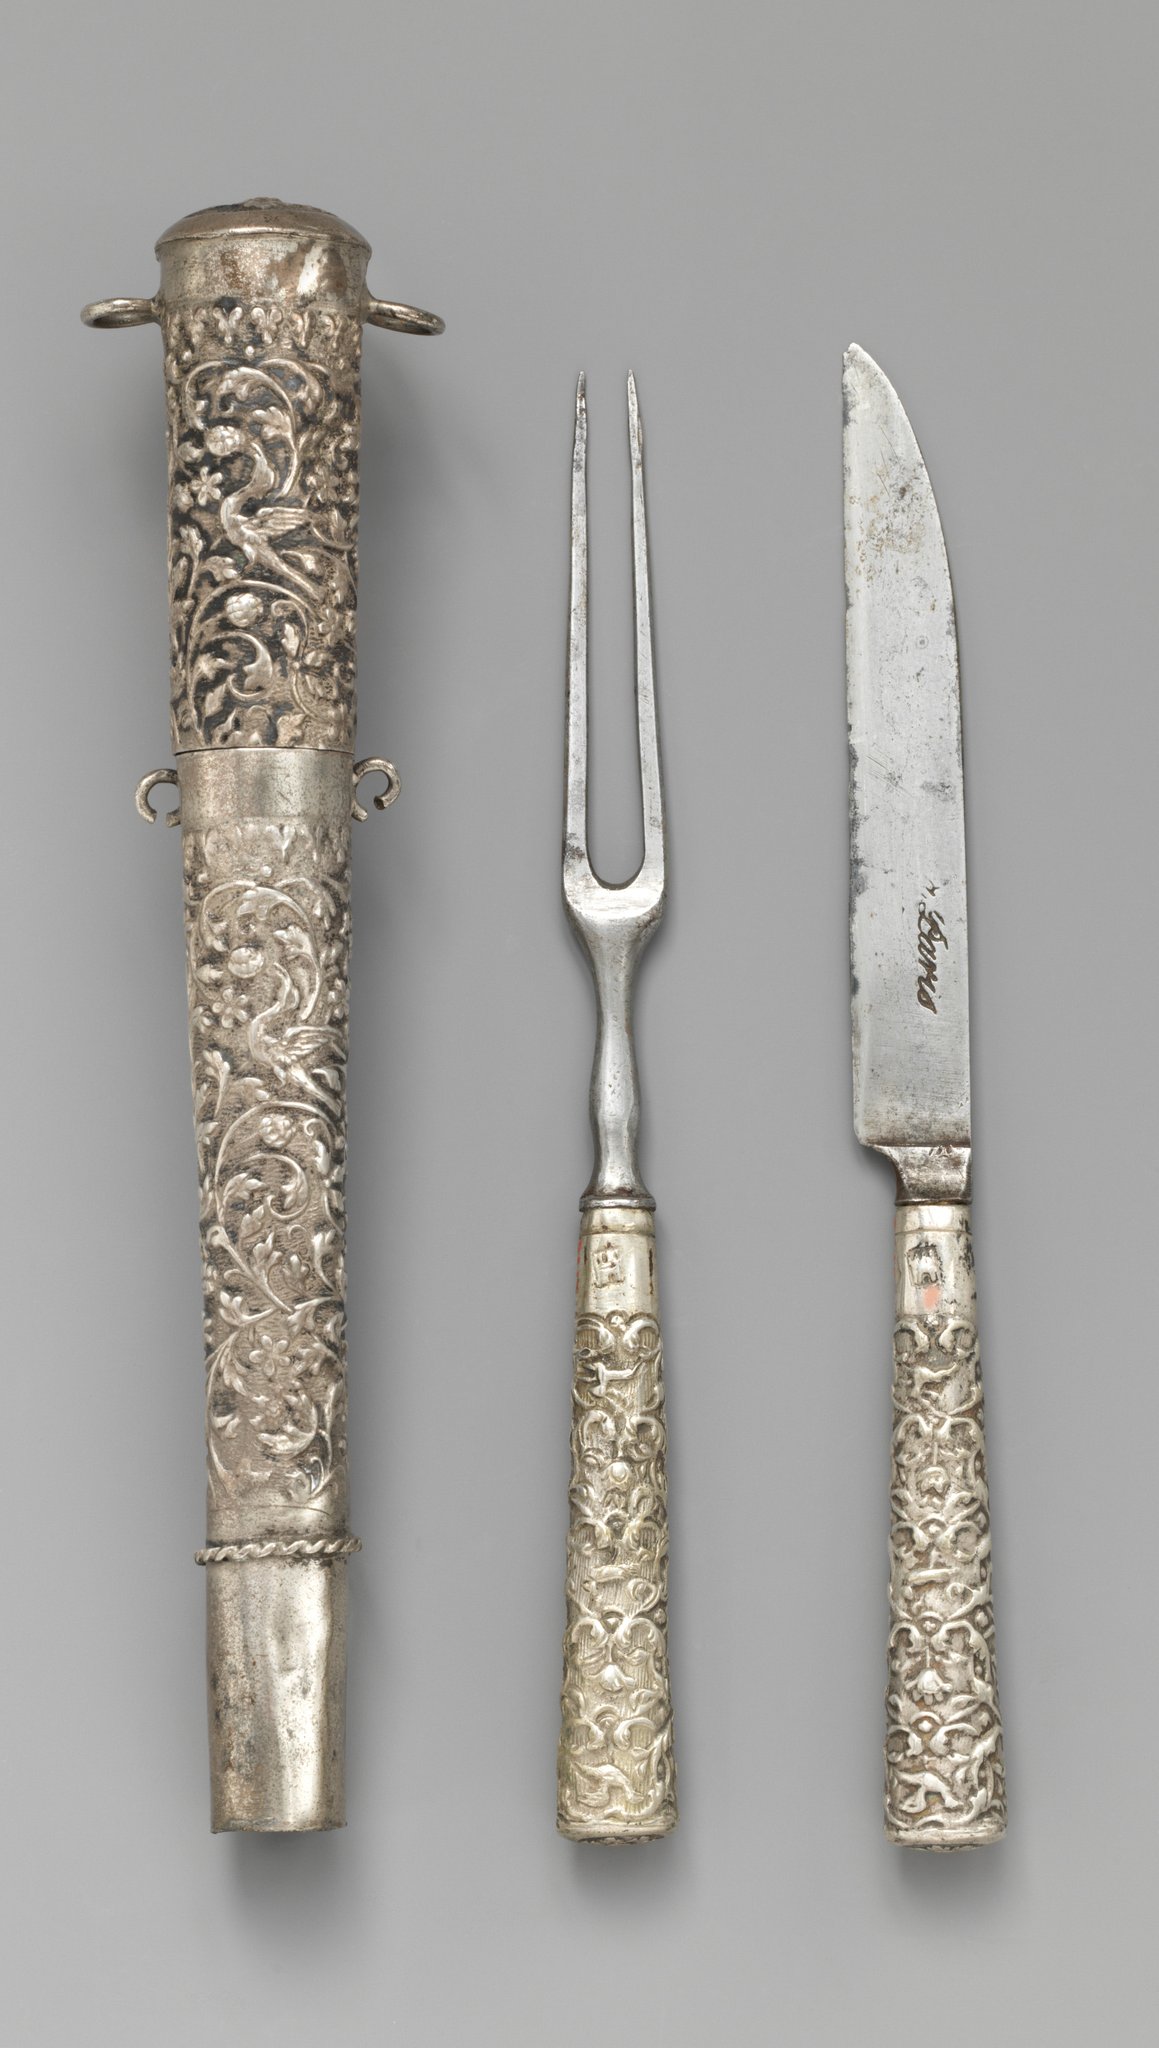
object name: knife and fork with case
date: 1601-1700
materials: steel